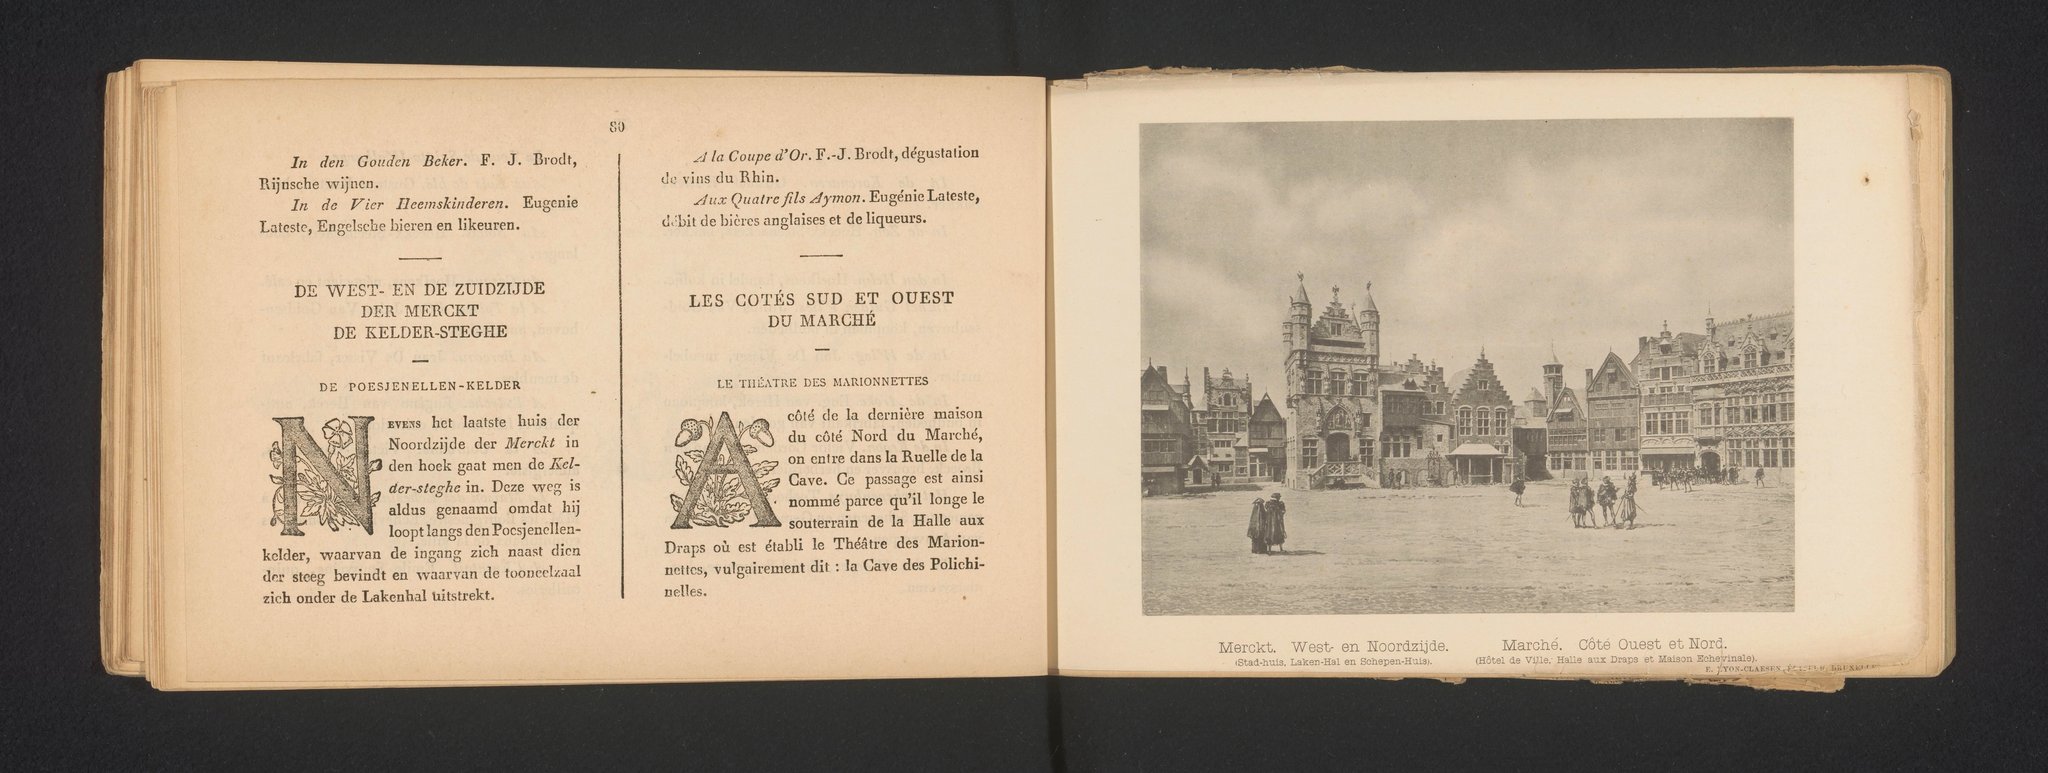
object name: page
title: Marché. Côté Ouest et Nord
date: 1889-1894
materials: paper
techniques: photograph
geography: brussels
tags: market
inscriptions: inscription: ‘(Stadhuis, Laken-Hal en Schepen-Huis). (Hôtel de Ville, Halle aux Draps et Maison Echevinale).’